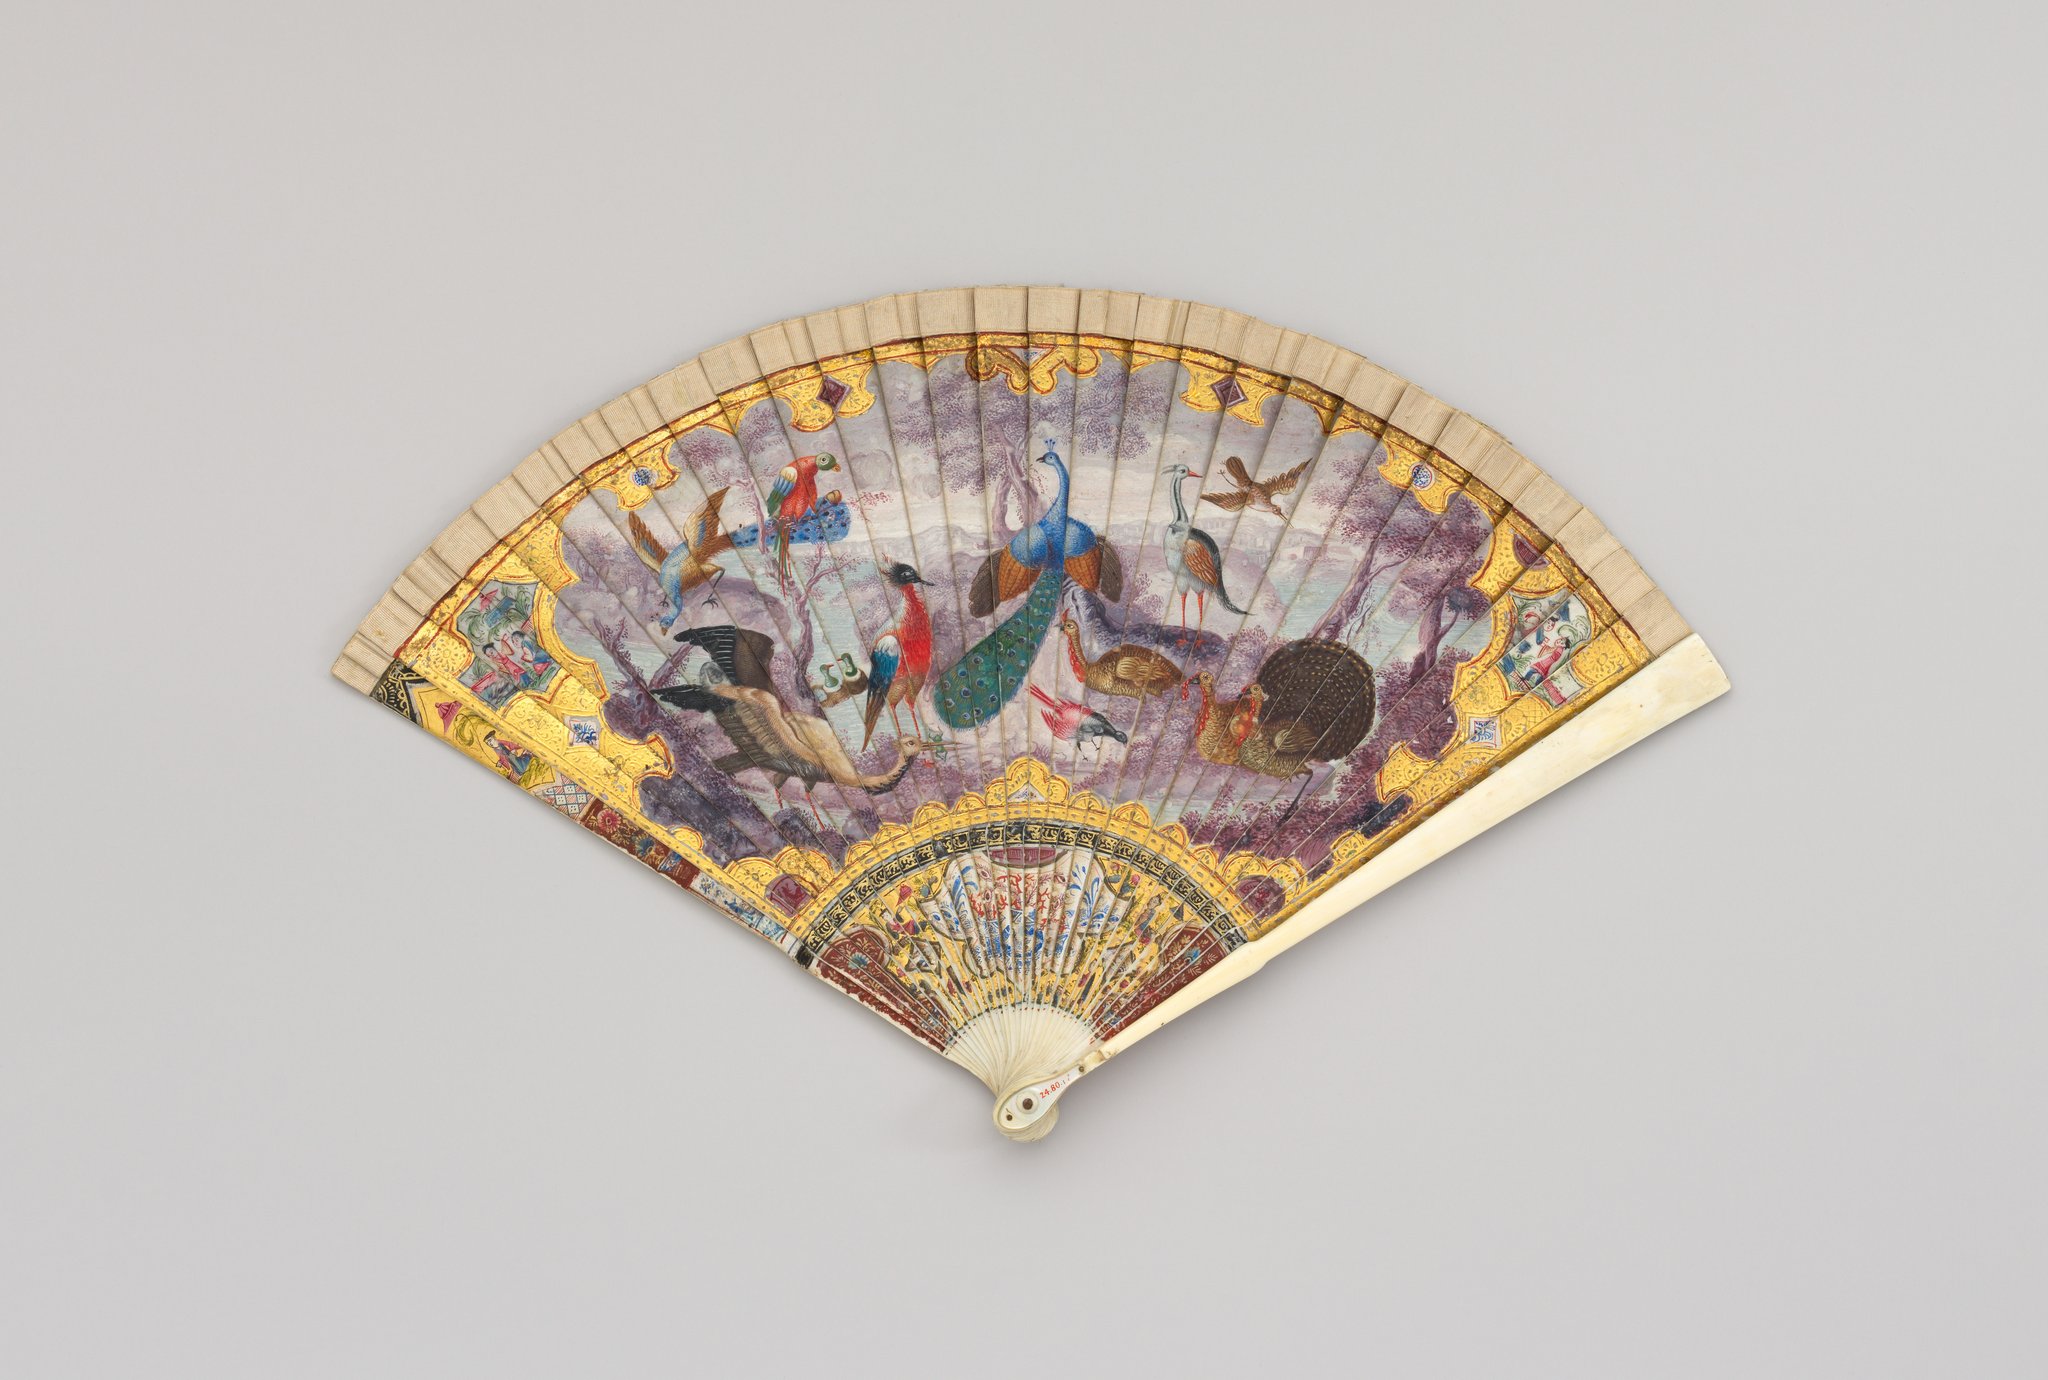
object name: fan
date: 1700-1723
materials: ivory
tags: birds,peacocks